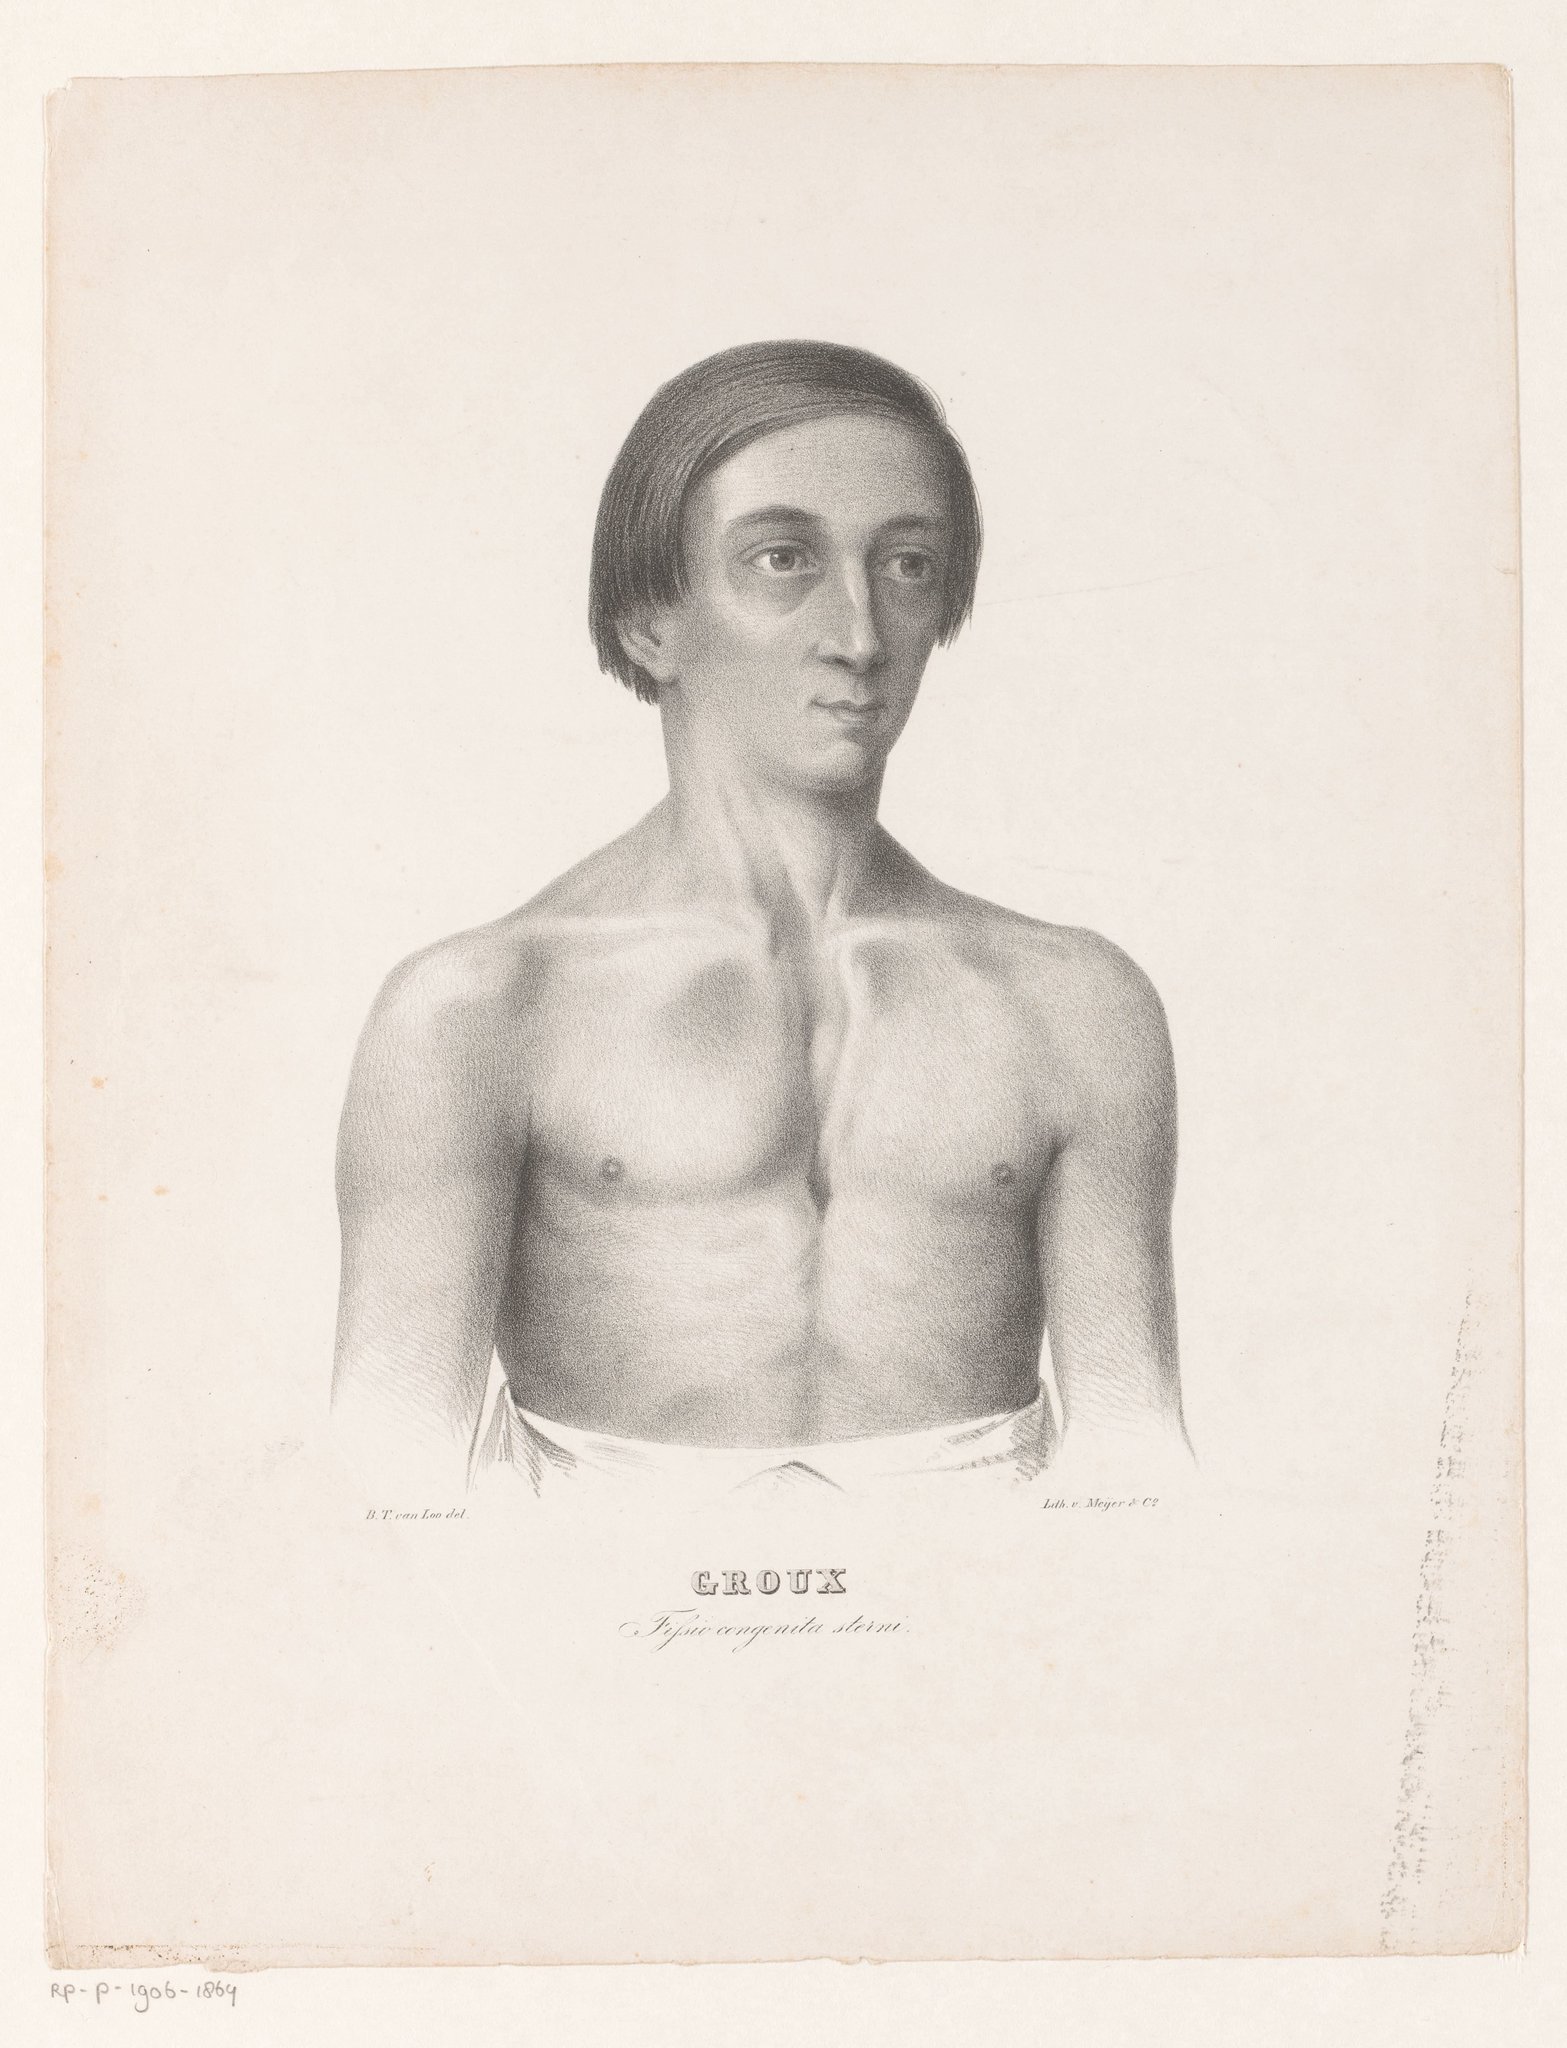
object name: print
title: Portret van E. Groux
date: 1843-1856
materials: paper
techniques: lithograph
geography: amsterdam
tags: disabilities, deformations, historical persons (+ half-length portrait)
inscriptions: collector's mark: Lugt 2228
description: De geportretteerde is met ontbloot bovenlijf afgebeeld zodat zijn aandoening, het ontbreken van het borstbeen, zichtbaar is. Onder zijn naam de naam van deze aandoening: fissura sterni congenita.